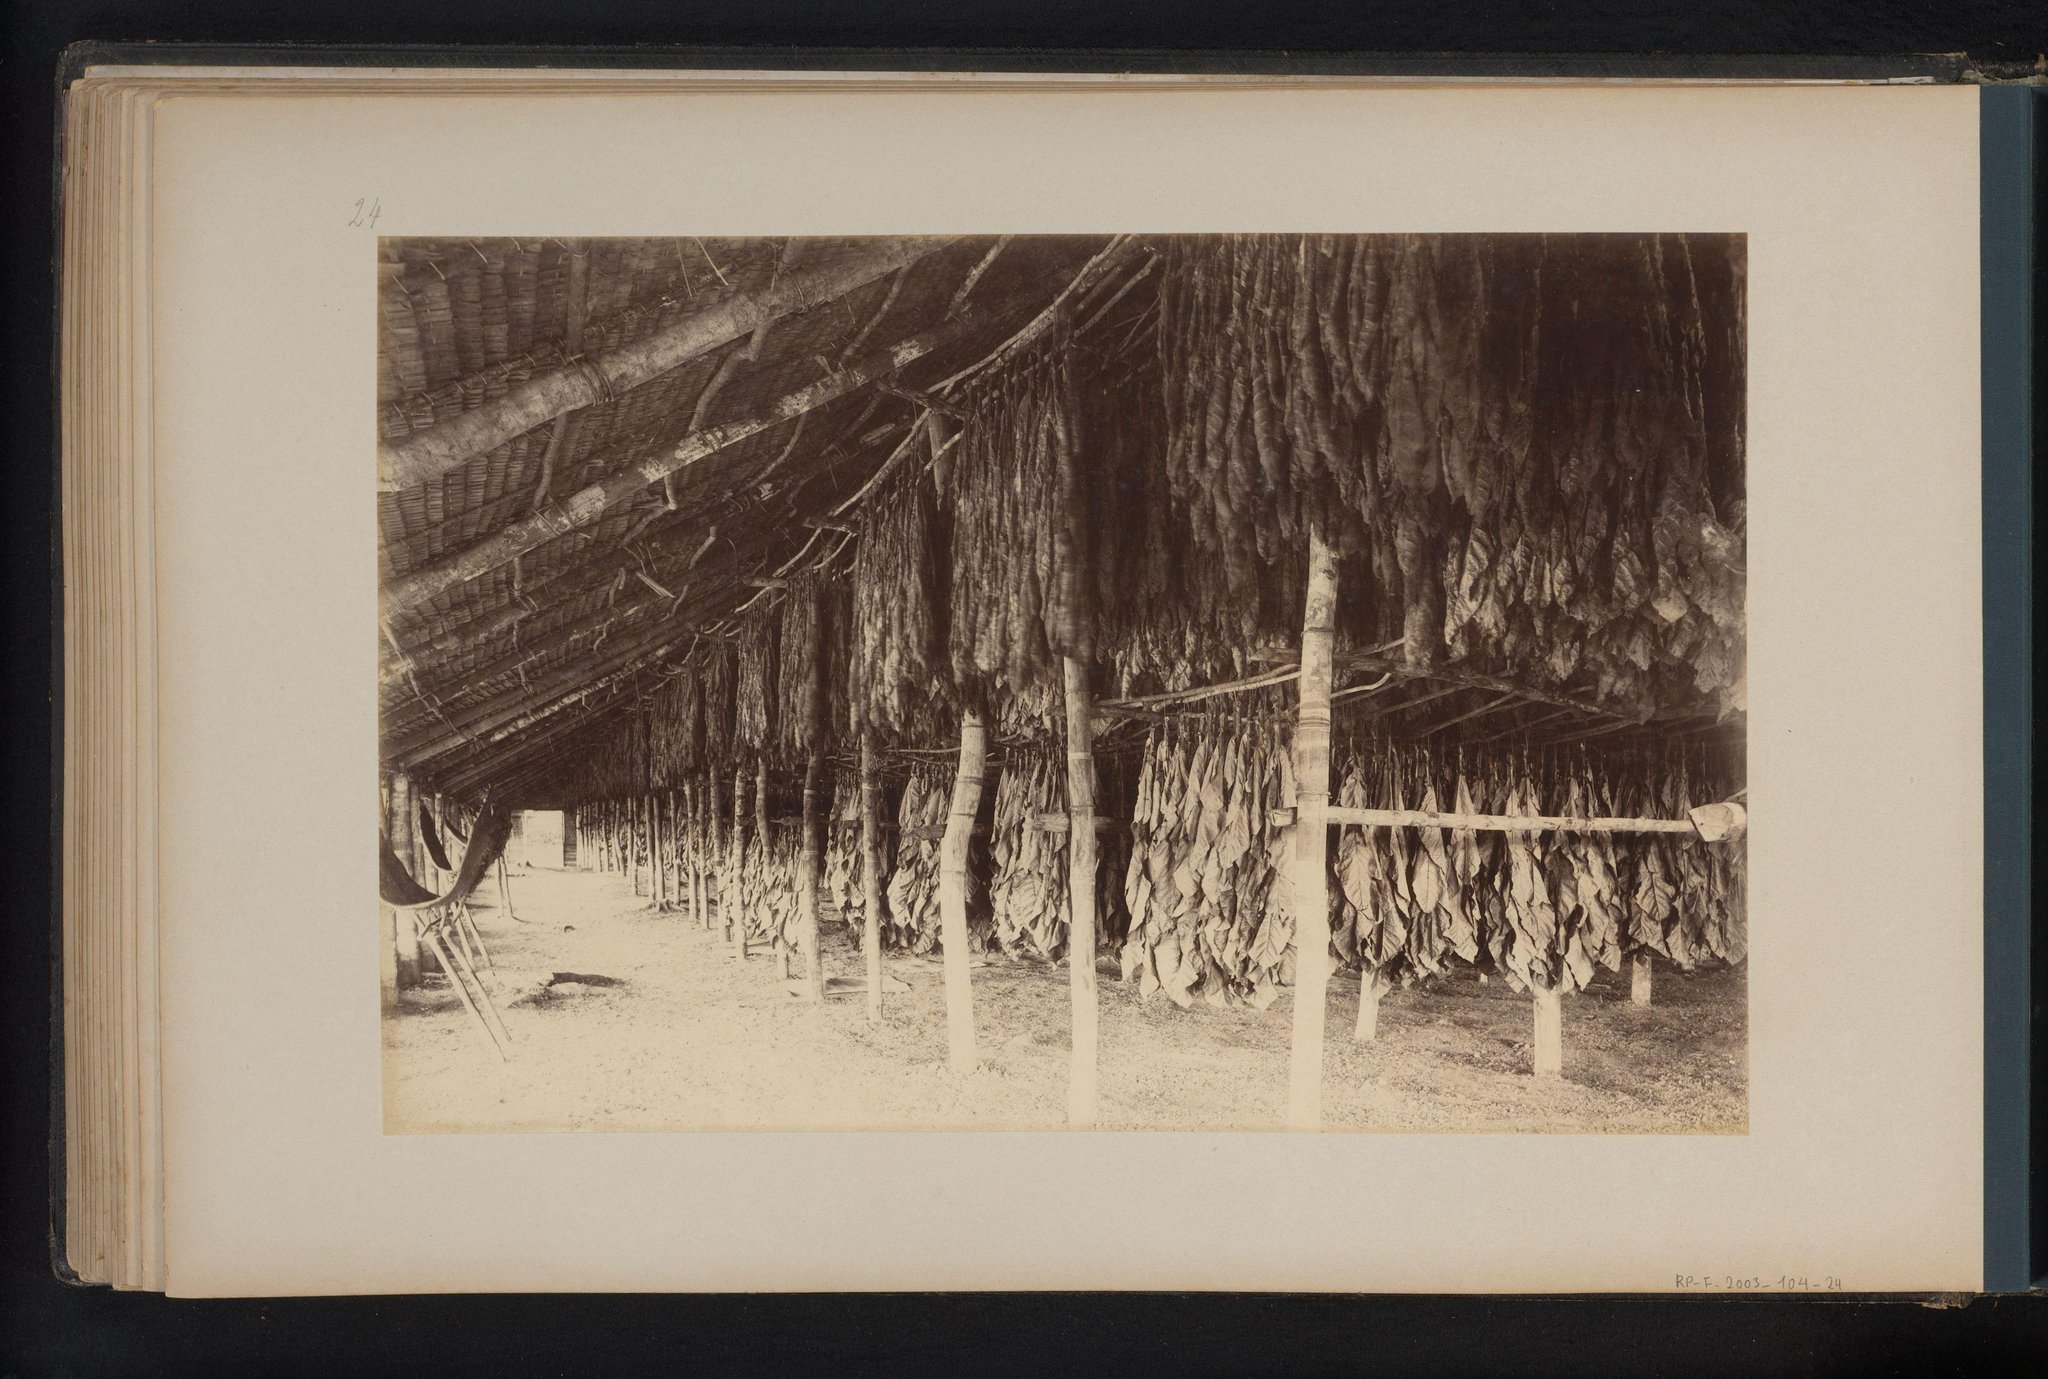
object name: photograph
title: Tabak in een droogschuur op de Rotterdam plantage, Sumatra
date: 1890-1900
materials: cardboard, photographic support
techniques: albumen print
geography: sumatra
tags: plantation, tobacco, sumatra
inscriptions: number: ‘24’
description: In de lijst van afbeeldingen wordt deze foto beschreven met de woorden "Tabak in Trockenscheune, Rotterdam-Estate".